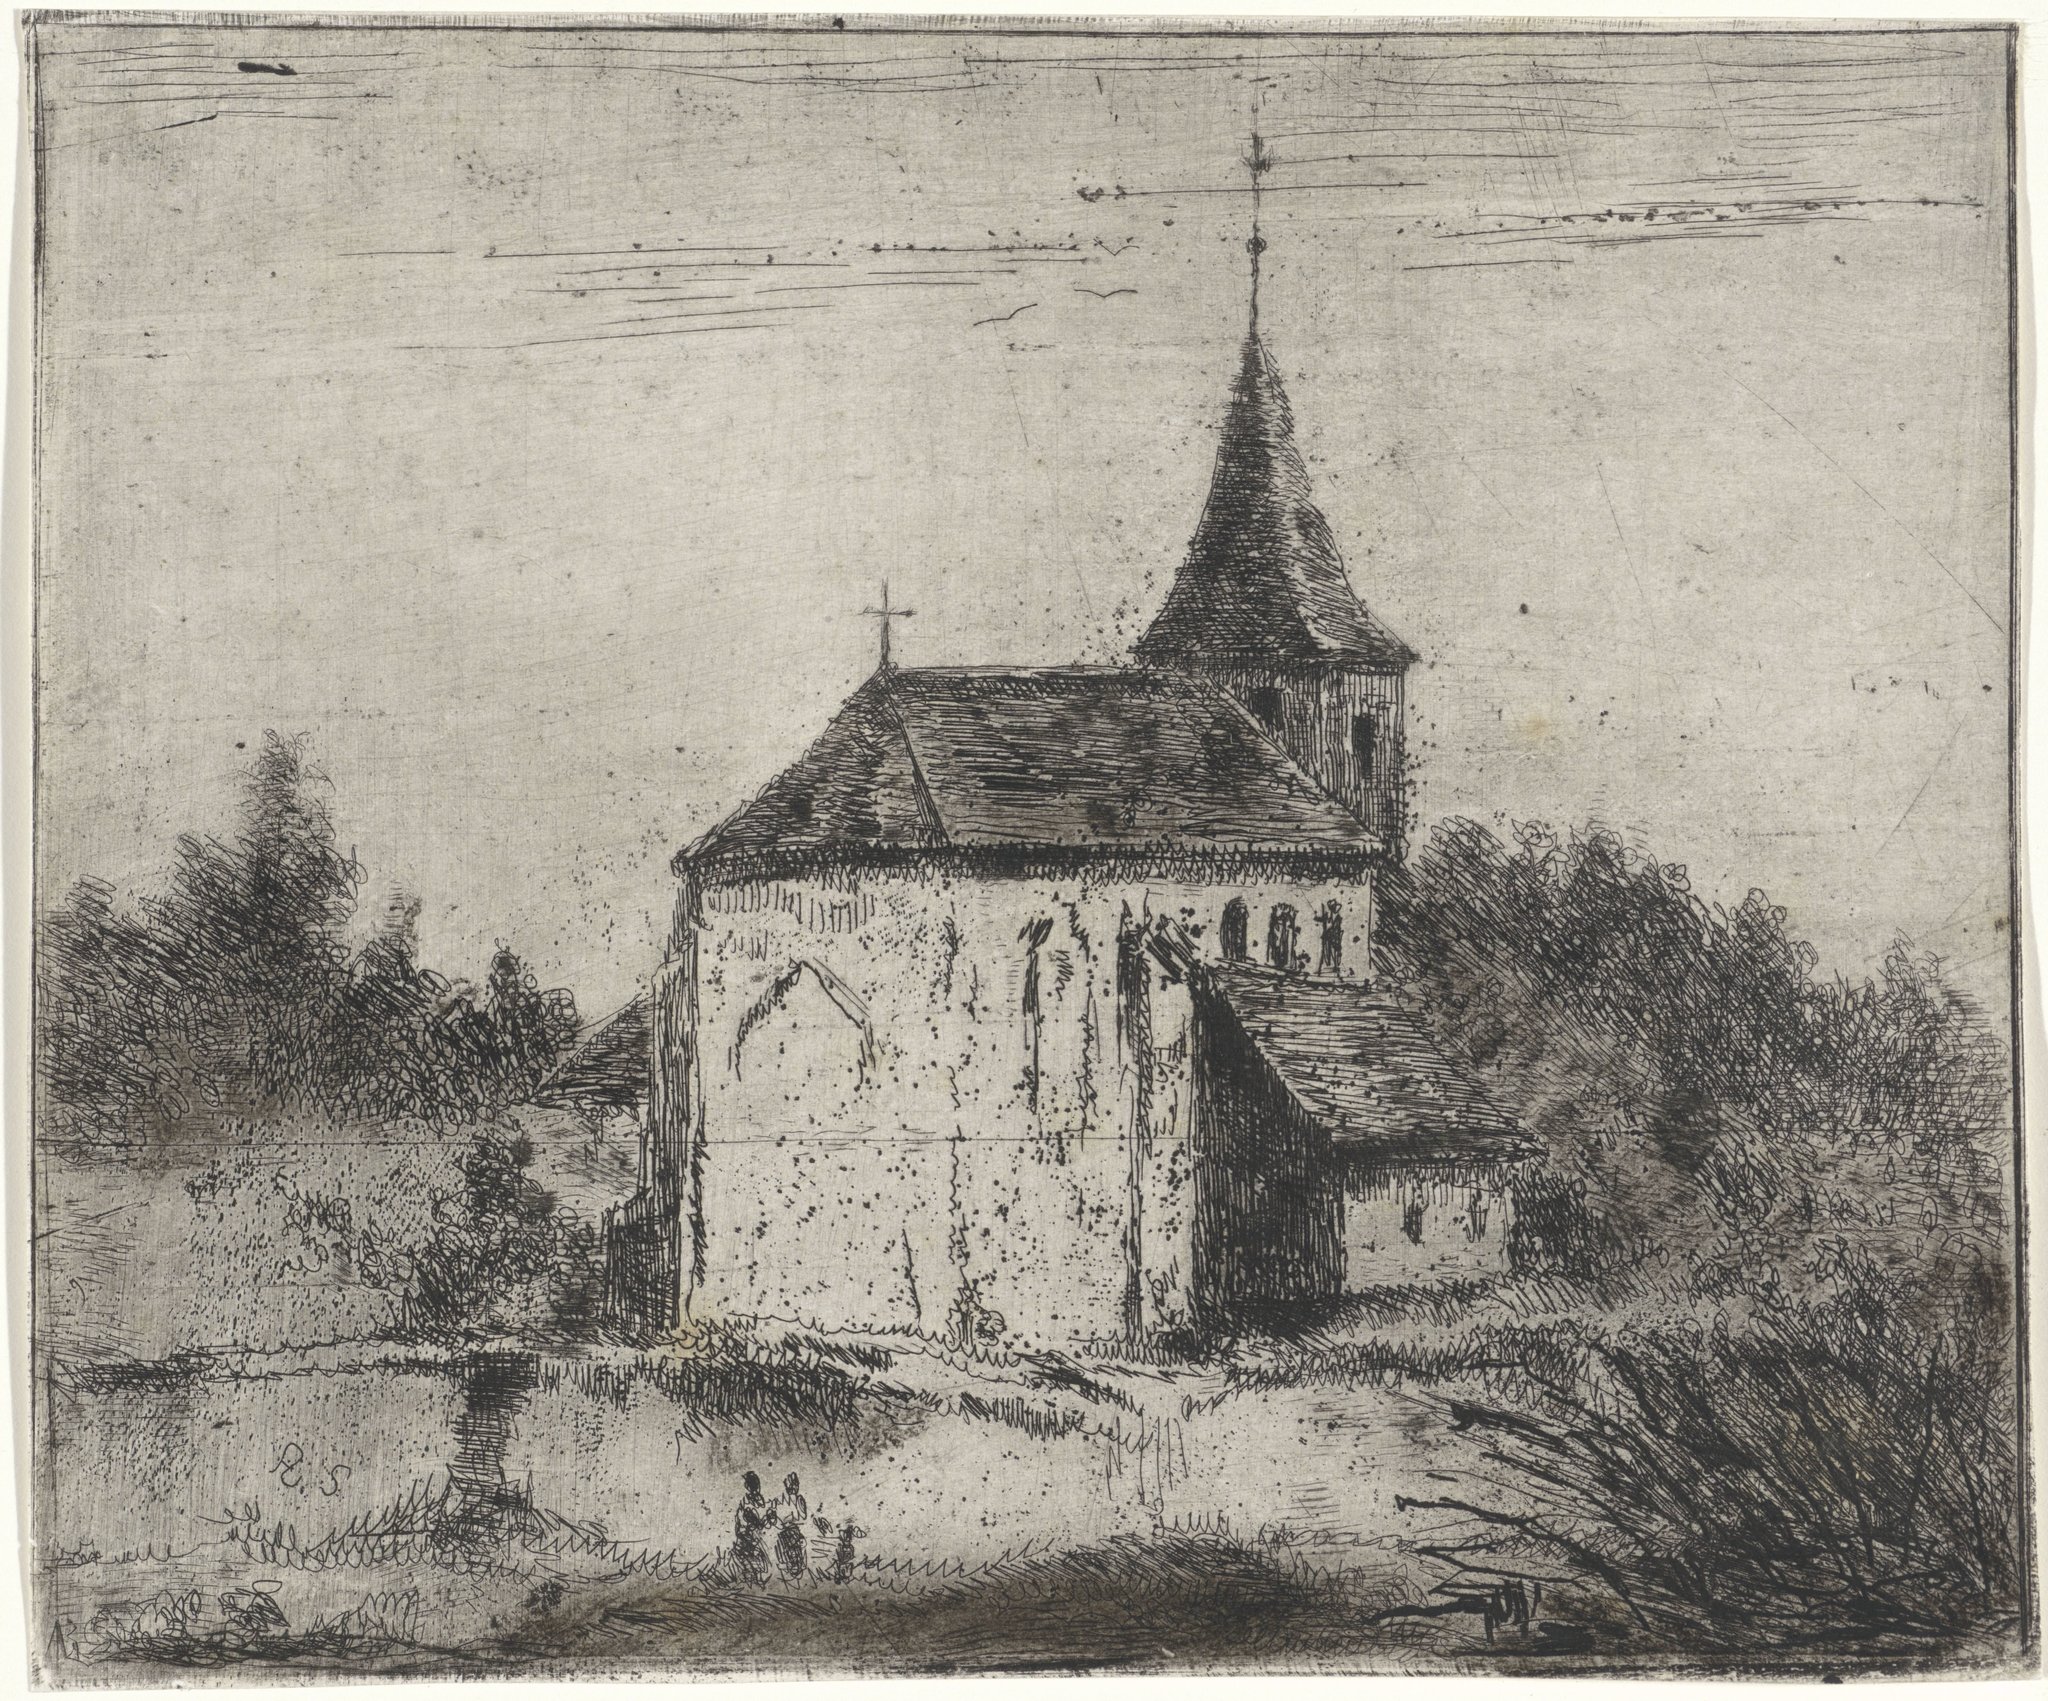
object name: print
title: Kleine kerk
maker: alexander schaepkens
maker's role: draughtsman, print maker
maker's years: 1815-1899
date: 1831-1904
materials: paper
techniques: drypoint, etching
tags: church (exterior)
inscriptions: collector's mark: Lugt 2228